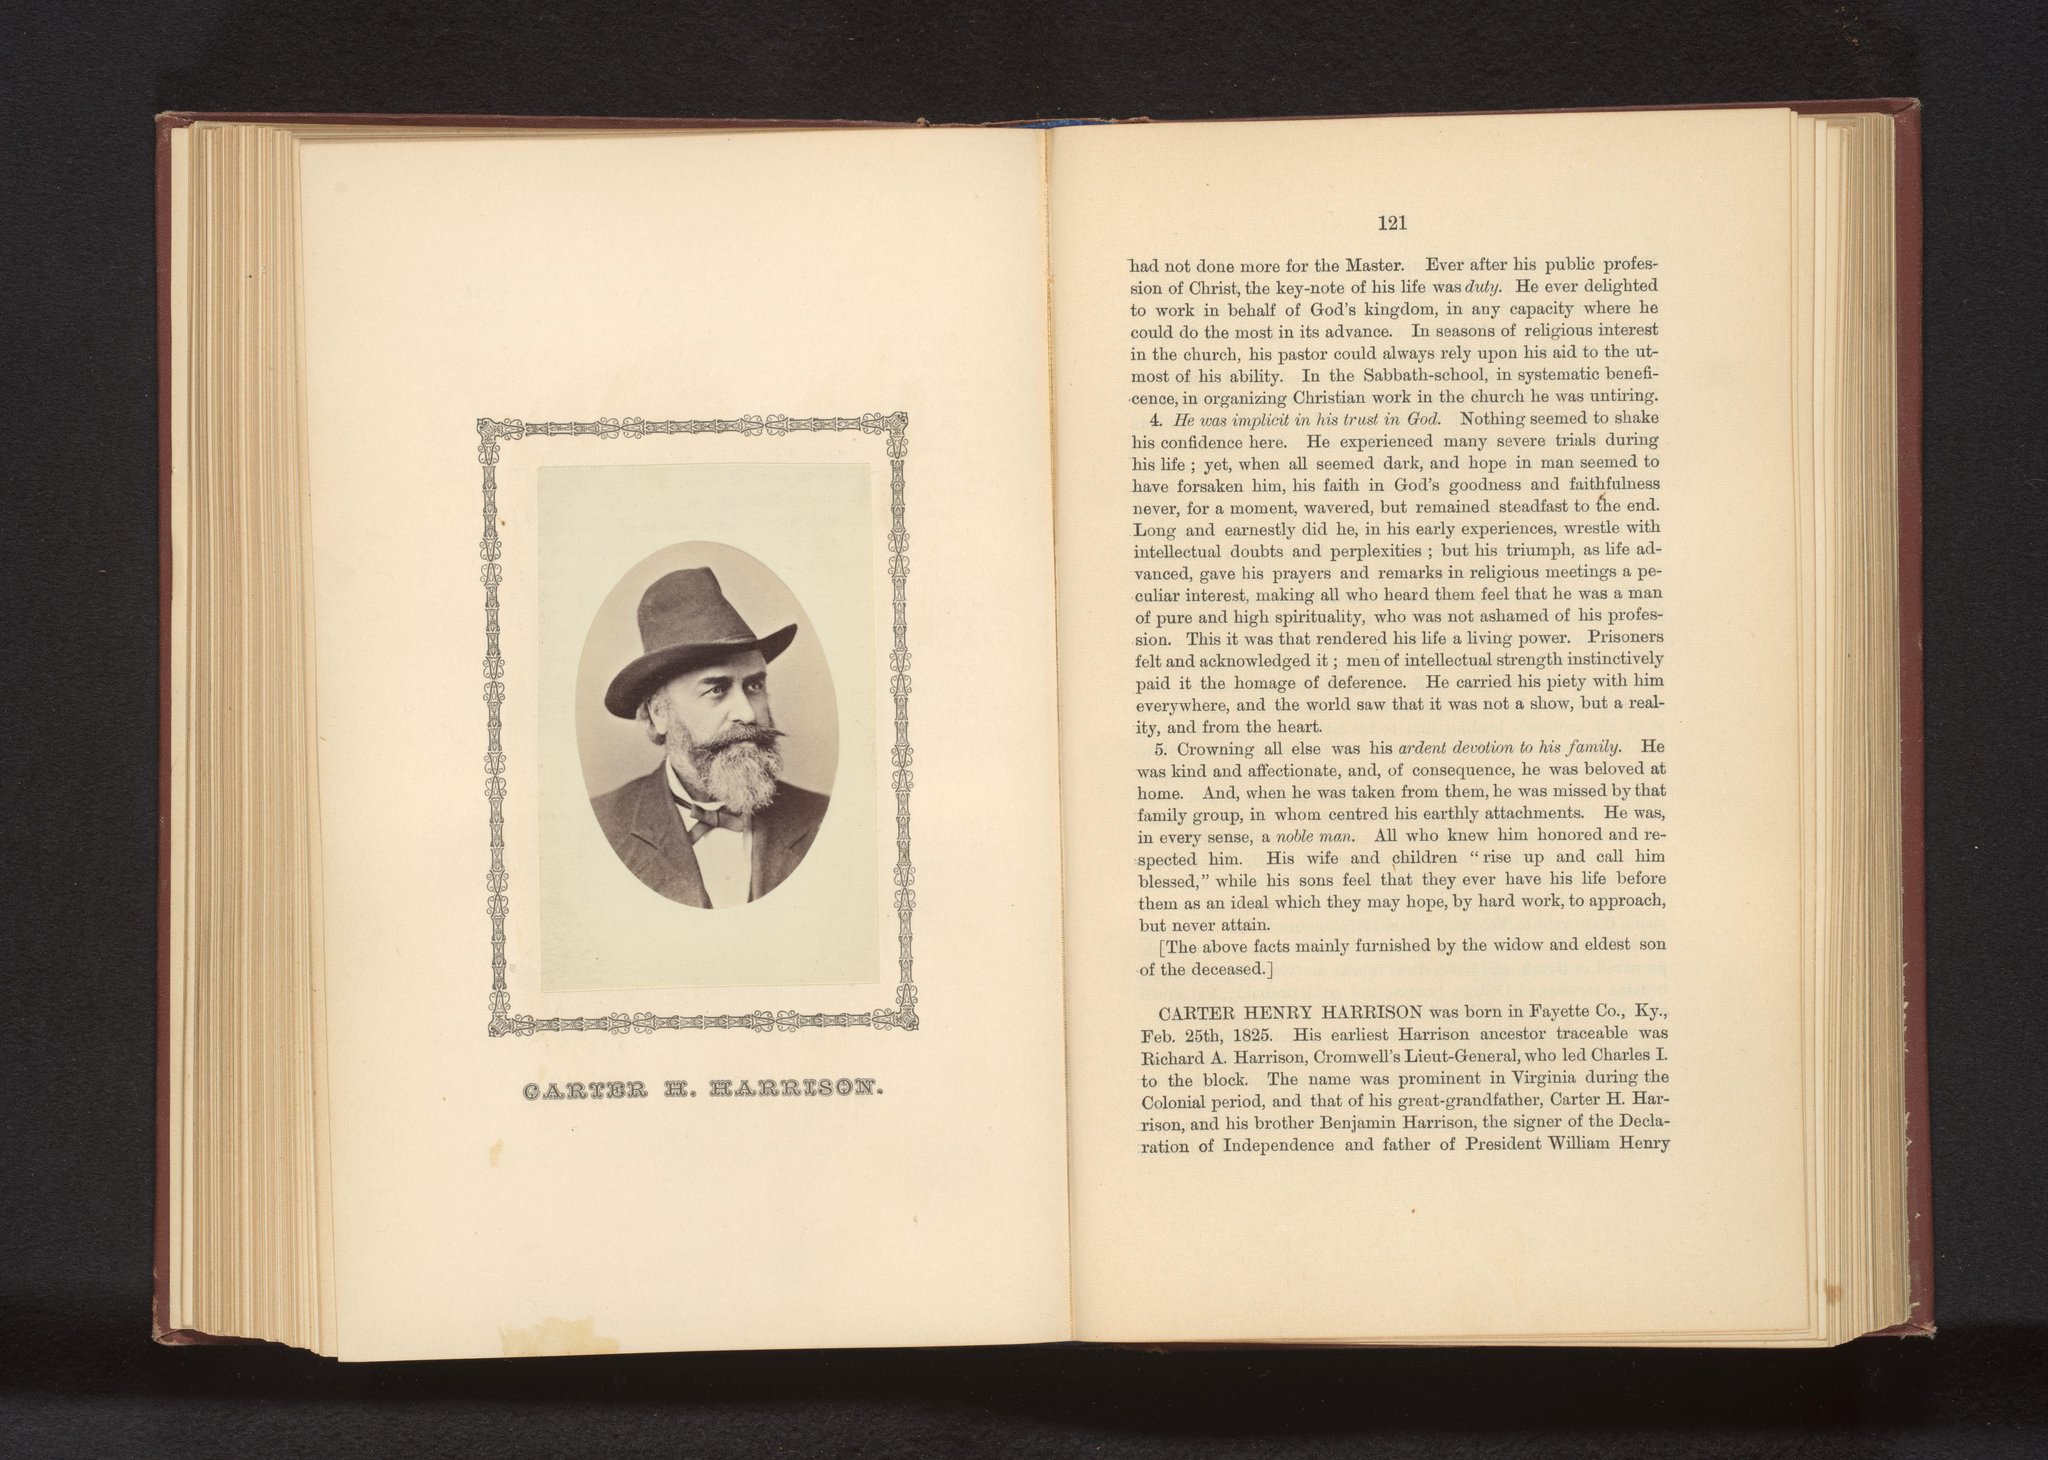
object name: photograph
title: Carter H. Harrison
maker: Anonymous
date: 1876-1881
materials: photographic support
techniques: albumen print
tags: politician, mayor, burgomaster